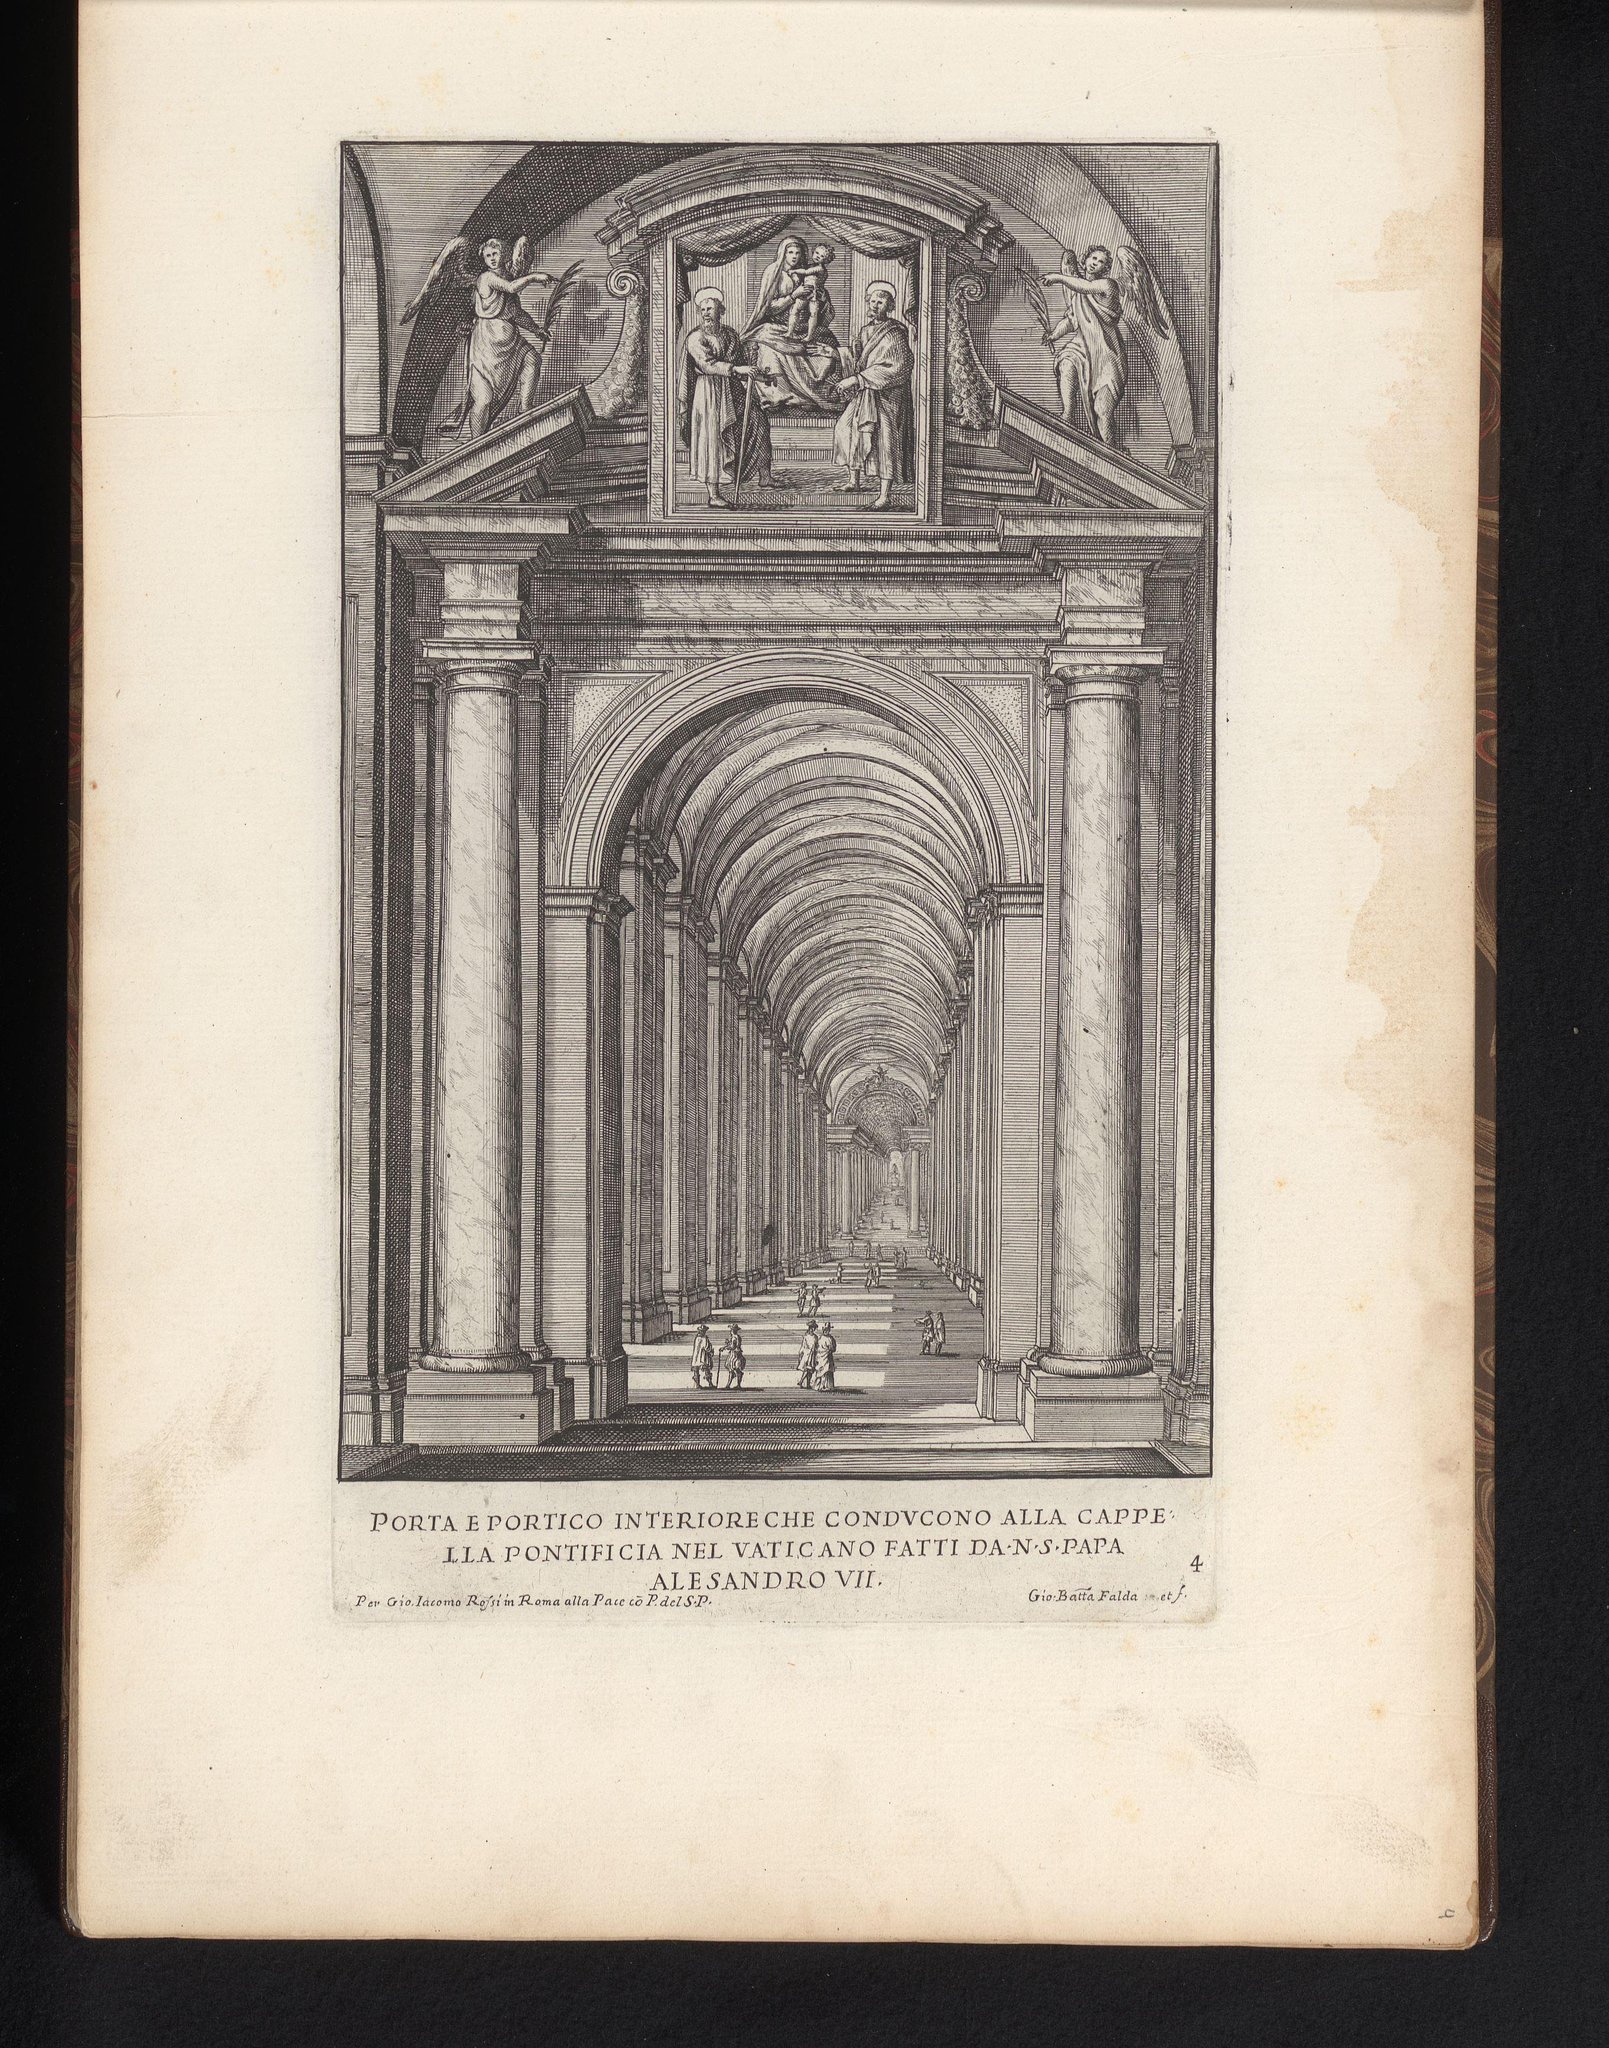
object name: album leaf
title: Scala Regia te Vaticaanstad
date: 1665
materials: paper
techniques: etching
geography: vatican city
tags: staircase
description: Deze prent maakt deel uit van een reeks van 35 prenten met voorstellingen van gebouwen in Rome. Samen met vier andere reeksen vormt het de grote reeks: 'Il nuovo teatro di Roma moderna'.